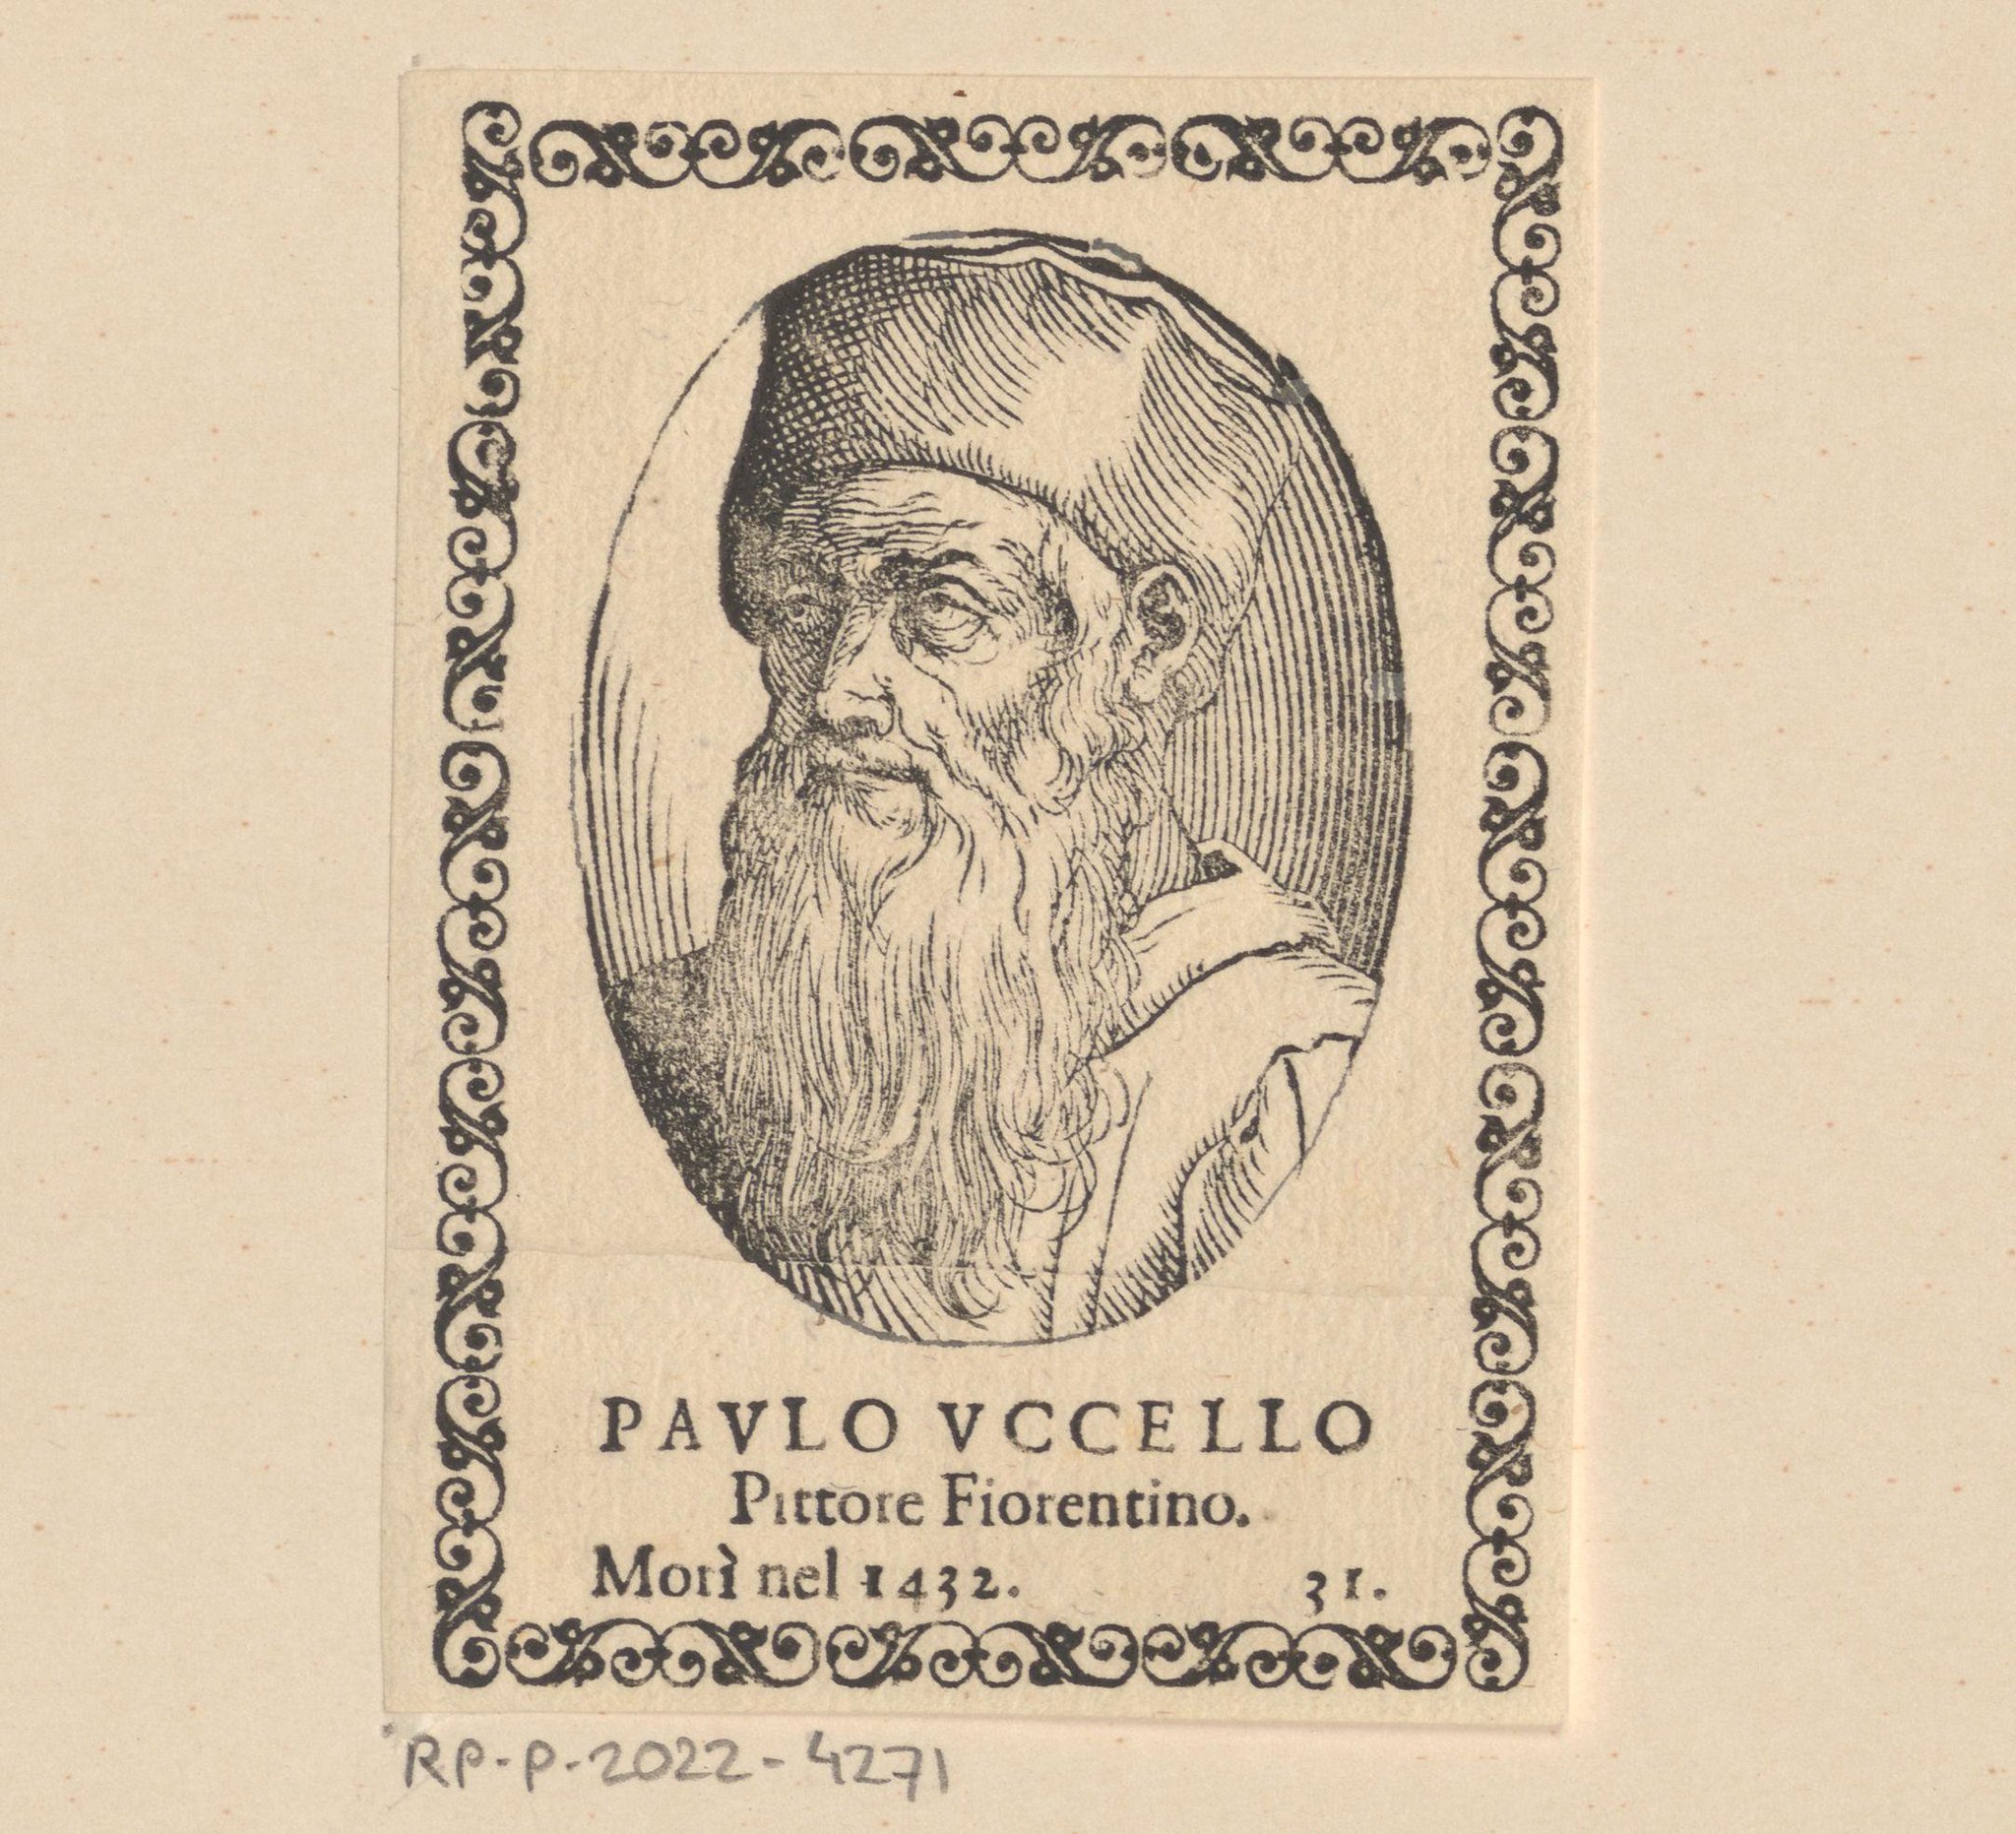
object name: print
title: Portret van Paolo Uccello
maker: cristoforo coriolano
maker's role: print maker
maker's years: 1540-1610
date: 1568-1650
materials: paper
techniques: letterpress printing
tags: painter, paolo uccello, historical persons, portrait, self-portrait of painter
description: Prent komt uit een editie van Vasari's 'Vite'. Prent met een andere omlijsting is gebruikt in de editie uit 1568: Vasari, Giorgio. Le vite de' piu eccellenti pittori scultori, e architettori. Florence: Filippo Giunta, 1568. En mogelijk in de editie uit 1647.